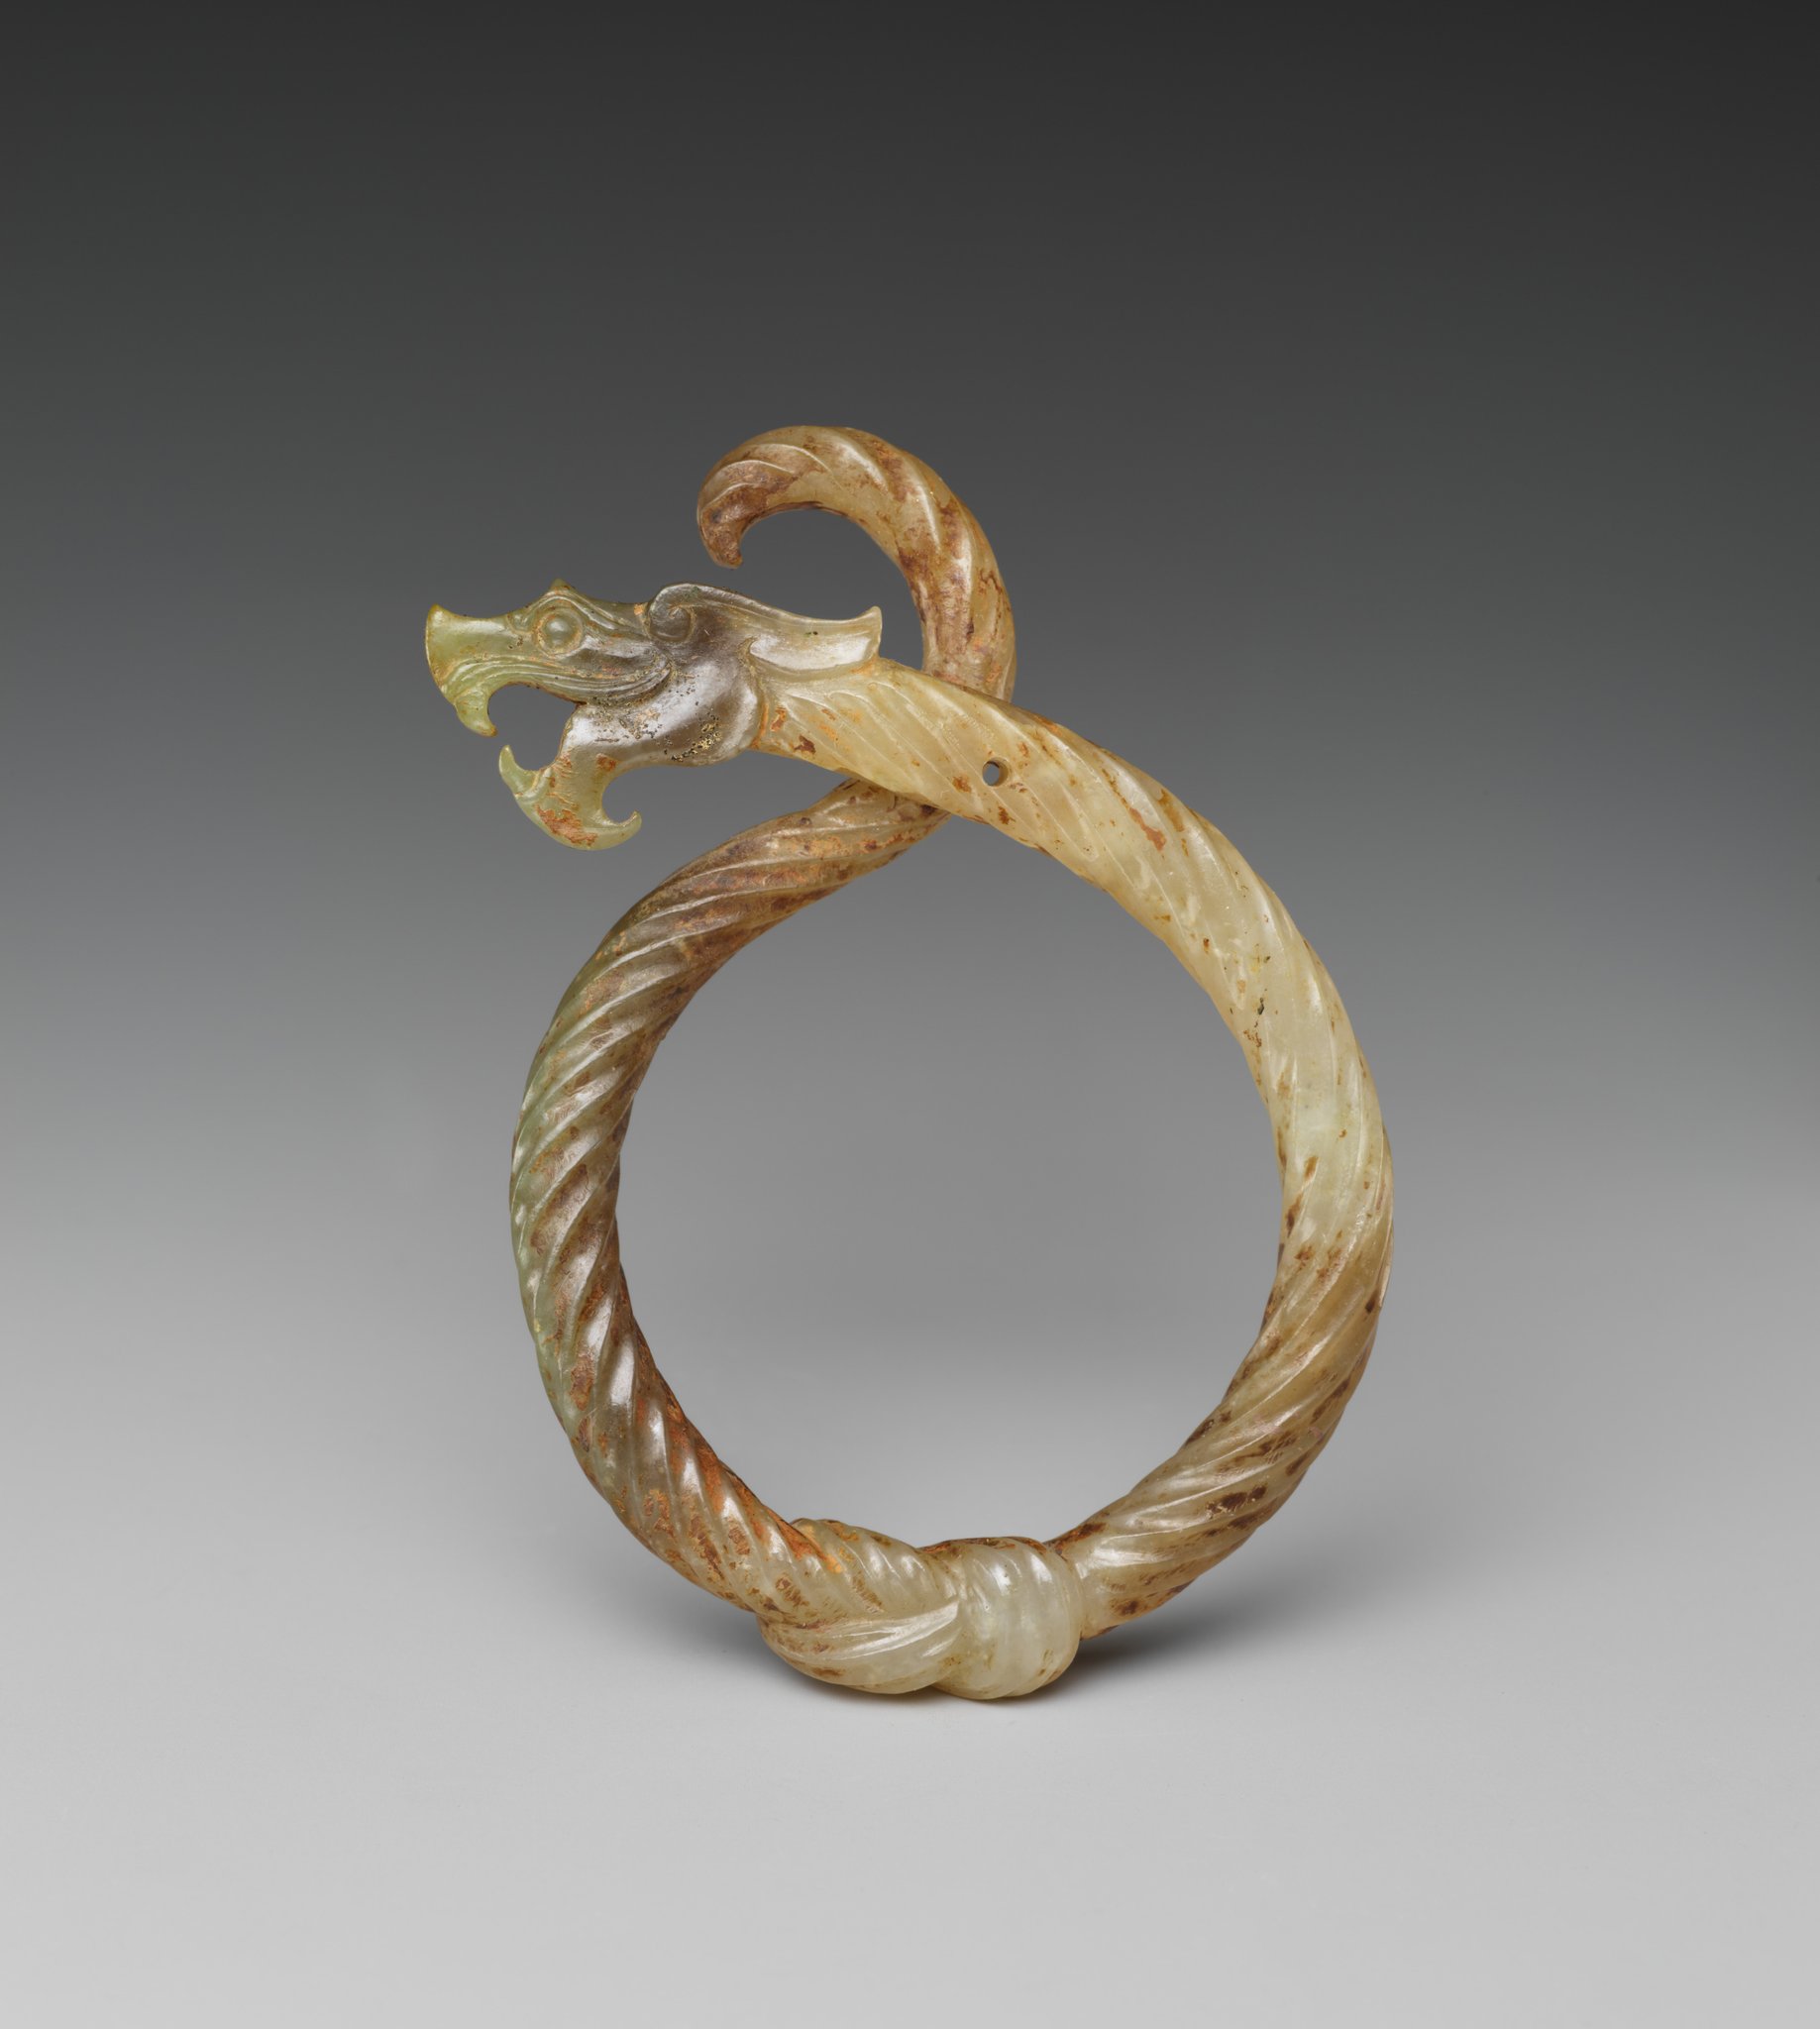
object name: pendant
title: Knotted dragon pendant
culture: chinese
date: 300-201 BCE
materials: jade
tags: dragons